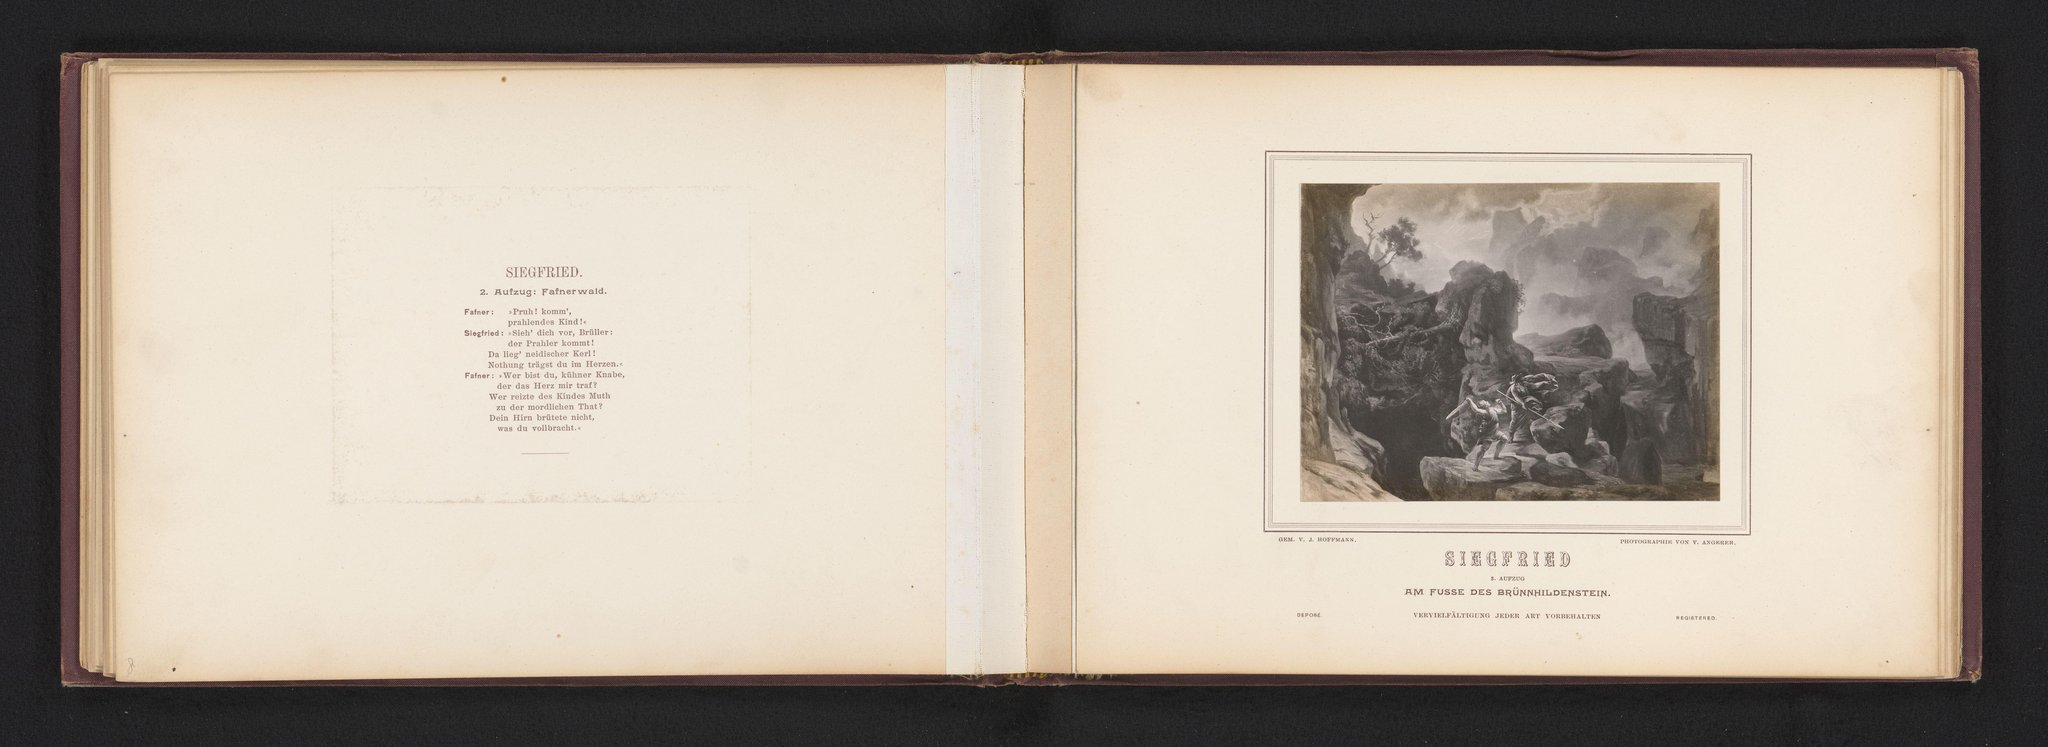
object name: photograph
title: Fotoreproductie van een schilderij, voorstellende Siegfried in gevecht met Wodan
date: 1866-1876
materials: photographic support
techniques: albumen print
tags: 'nibelungenlied', odin, god of occult wisdom, siegfried, battle, fighting in general